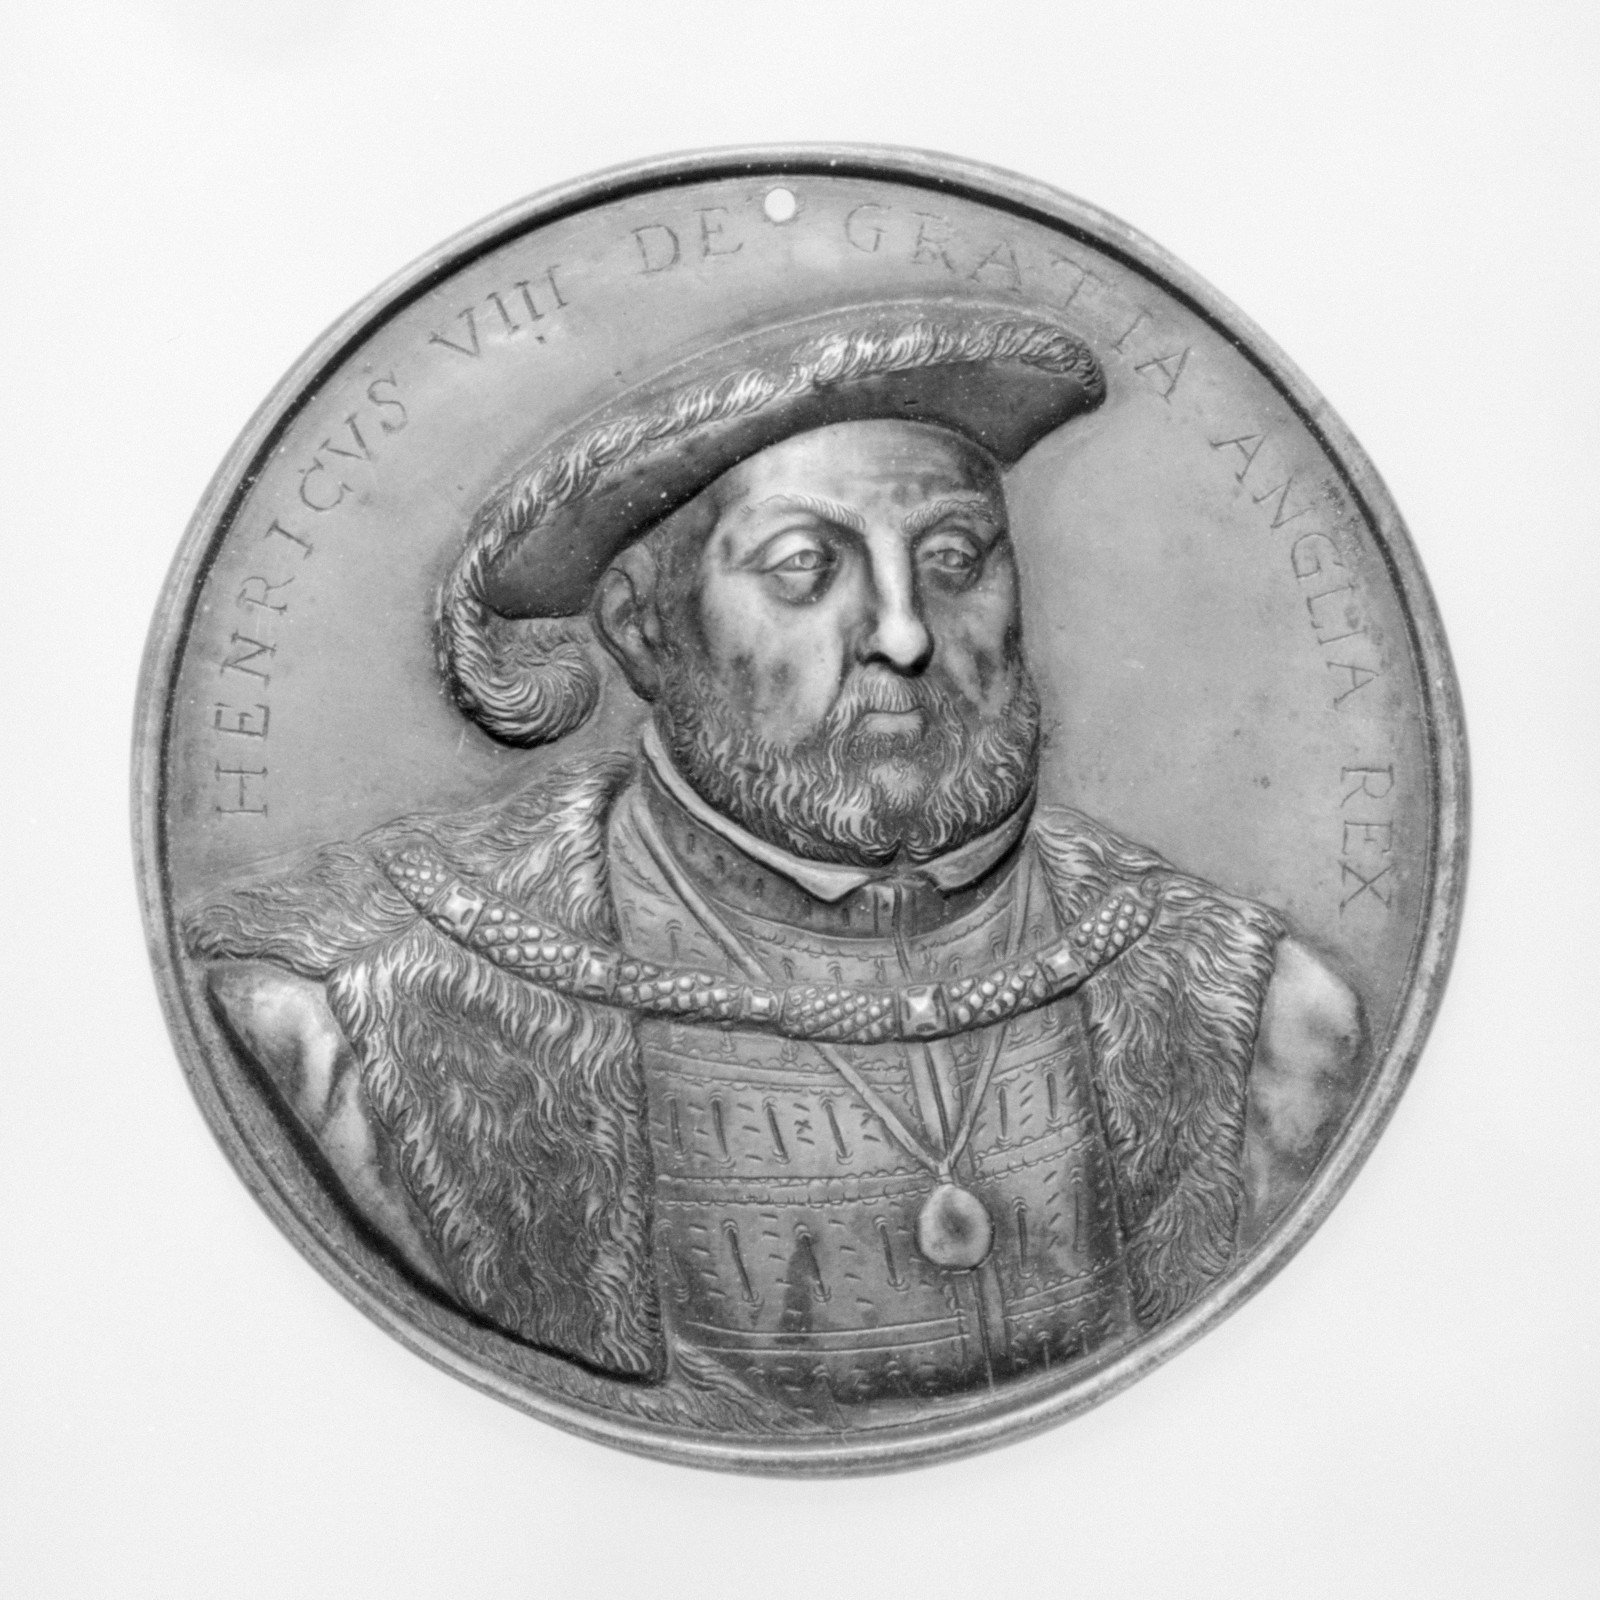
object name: medal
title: Henry VIII, King of England (1491–1547, r. 1509–47)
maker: steven cornelisz van herwijck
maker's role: artist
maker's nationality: netherlandish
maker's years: 1525-1575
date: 1501-1700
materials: bronze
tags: henry viii,kings,portraits